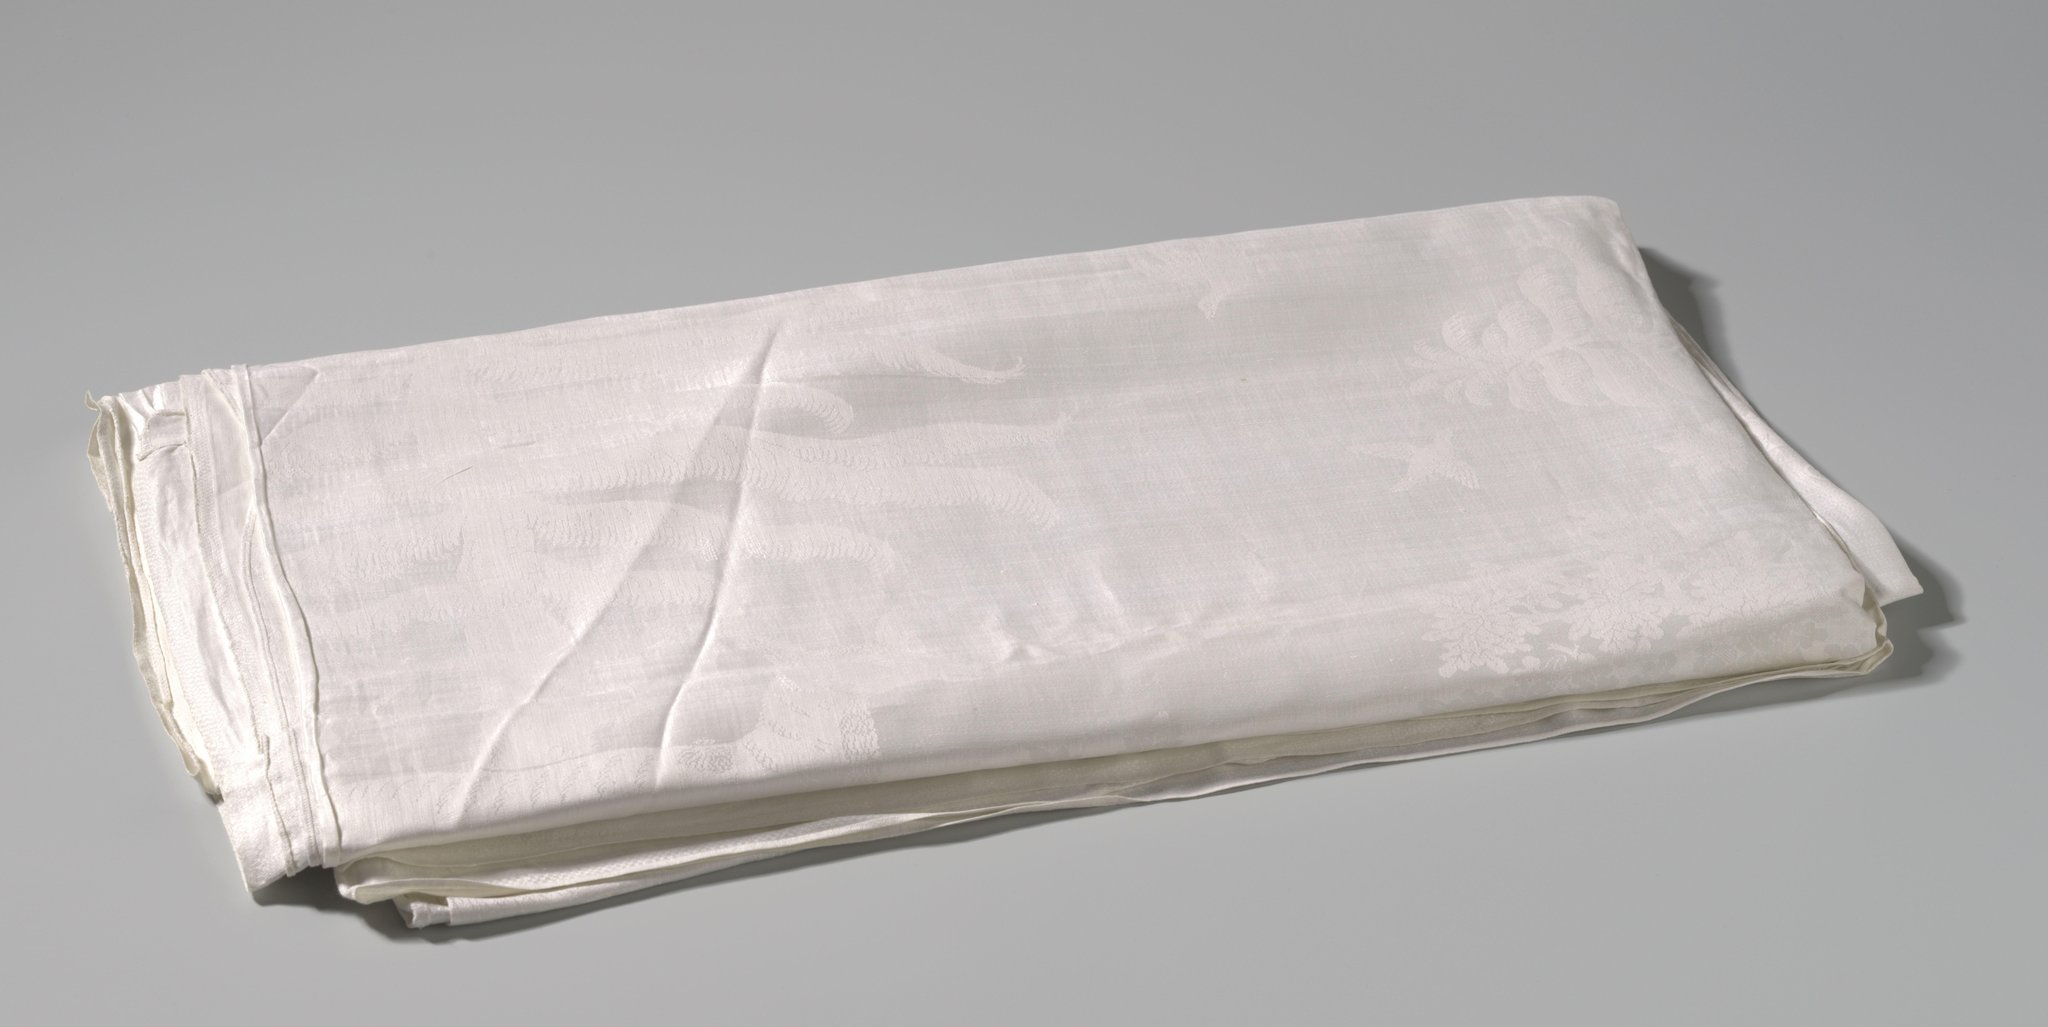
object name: tablecloth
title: Tafellaken met een jachttafereel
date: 1800-1825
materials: linen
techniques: damask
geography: boxtel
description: Tafellaken van linnendamast met een jachttafereel. Middenveld; tweemaal drie rustende herten op bosgrondje met paddenstoelen en bladplanten met links een spar en rechts een eik, langs de zijden jachtgezelschap. Tussen bomen jagers te paard met steek en jachthoorn, voetknechten en honden achter hert en wild zwijn jagend. In hoeken overhoeks staand hert in rivier met uitgegroeid gewei, opvliegende vogels. Korte zijden: geknielde man op hert en haas schietend. Rand: hoorn des overvloeds met voluten en zwaan.